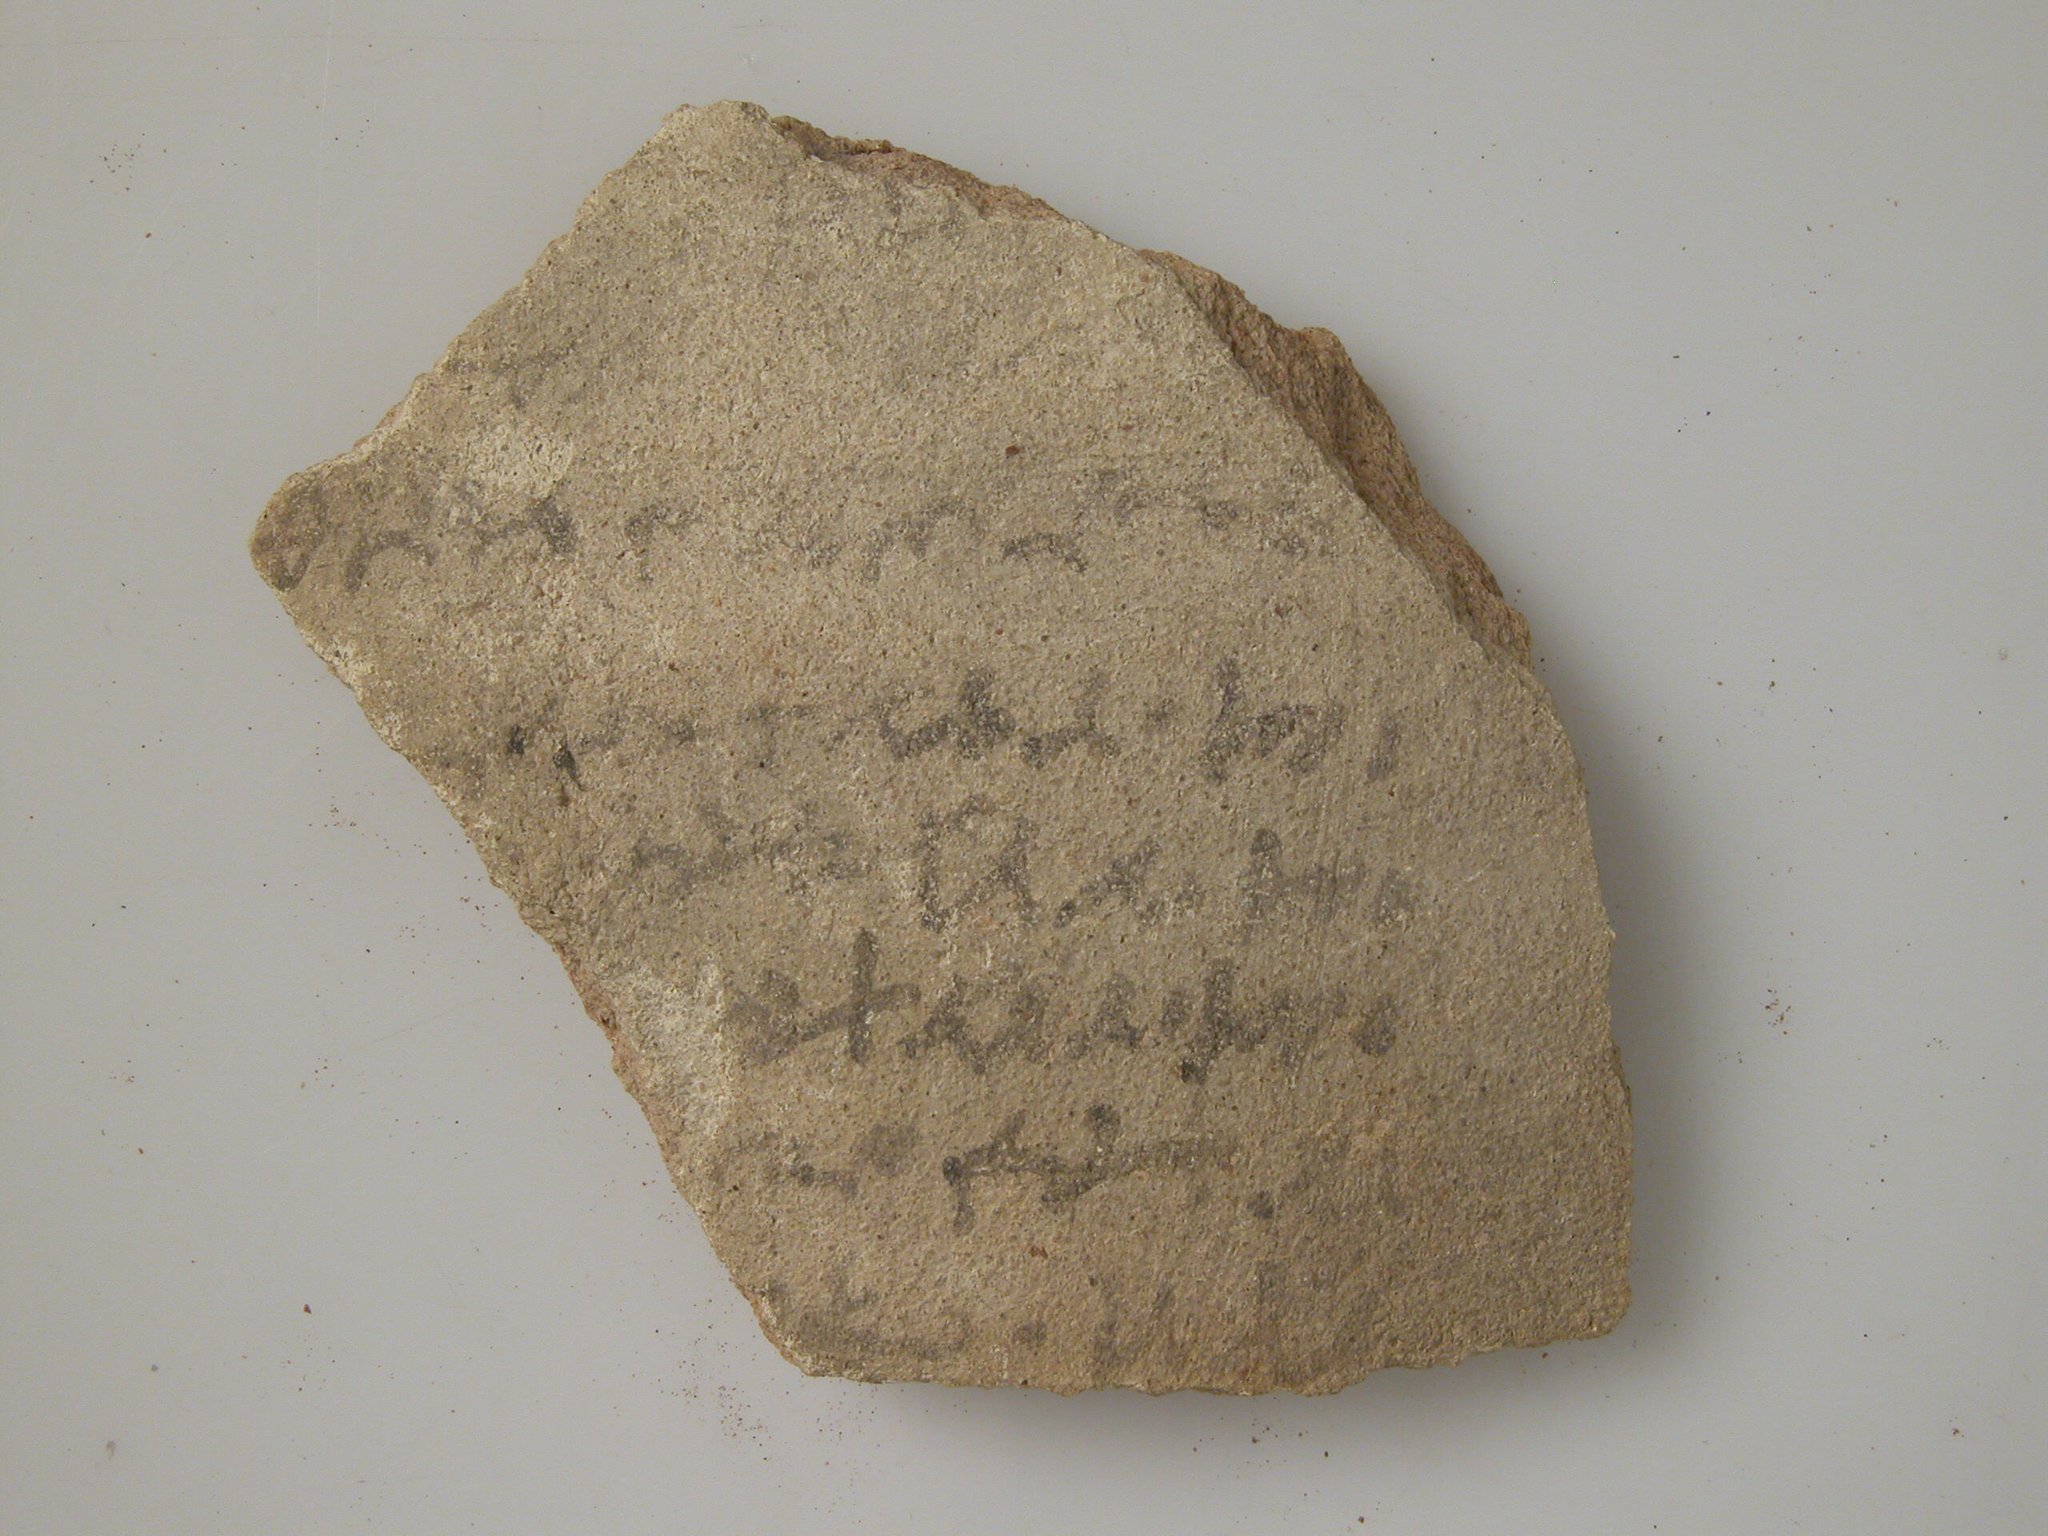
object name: ostrakon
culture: coptic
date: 301-700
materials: ink, pottery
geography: egypt